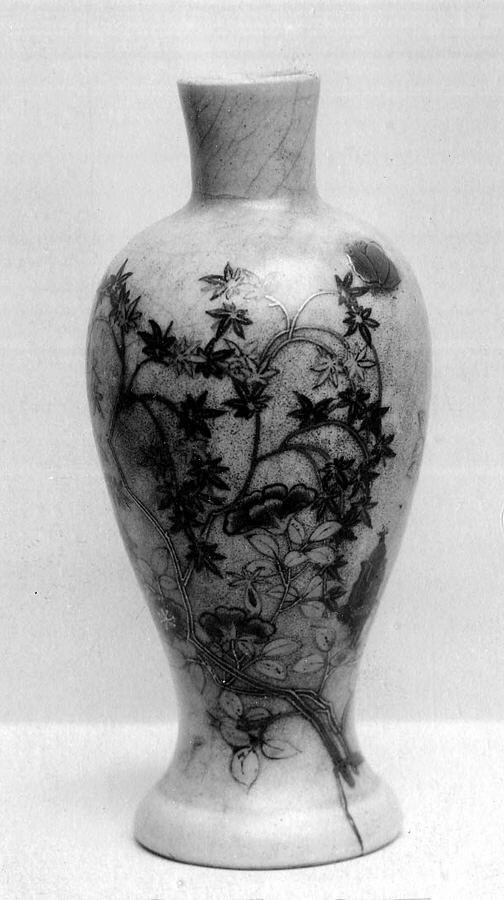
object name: vase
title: Small Vase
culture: japanese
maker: zenshiro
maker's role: artist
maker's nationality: japanese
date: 1820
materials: enamel, gold, lacquer, pottery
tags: leaves